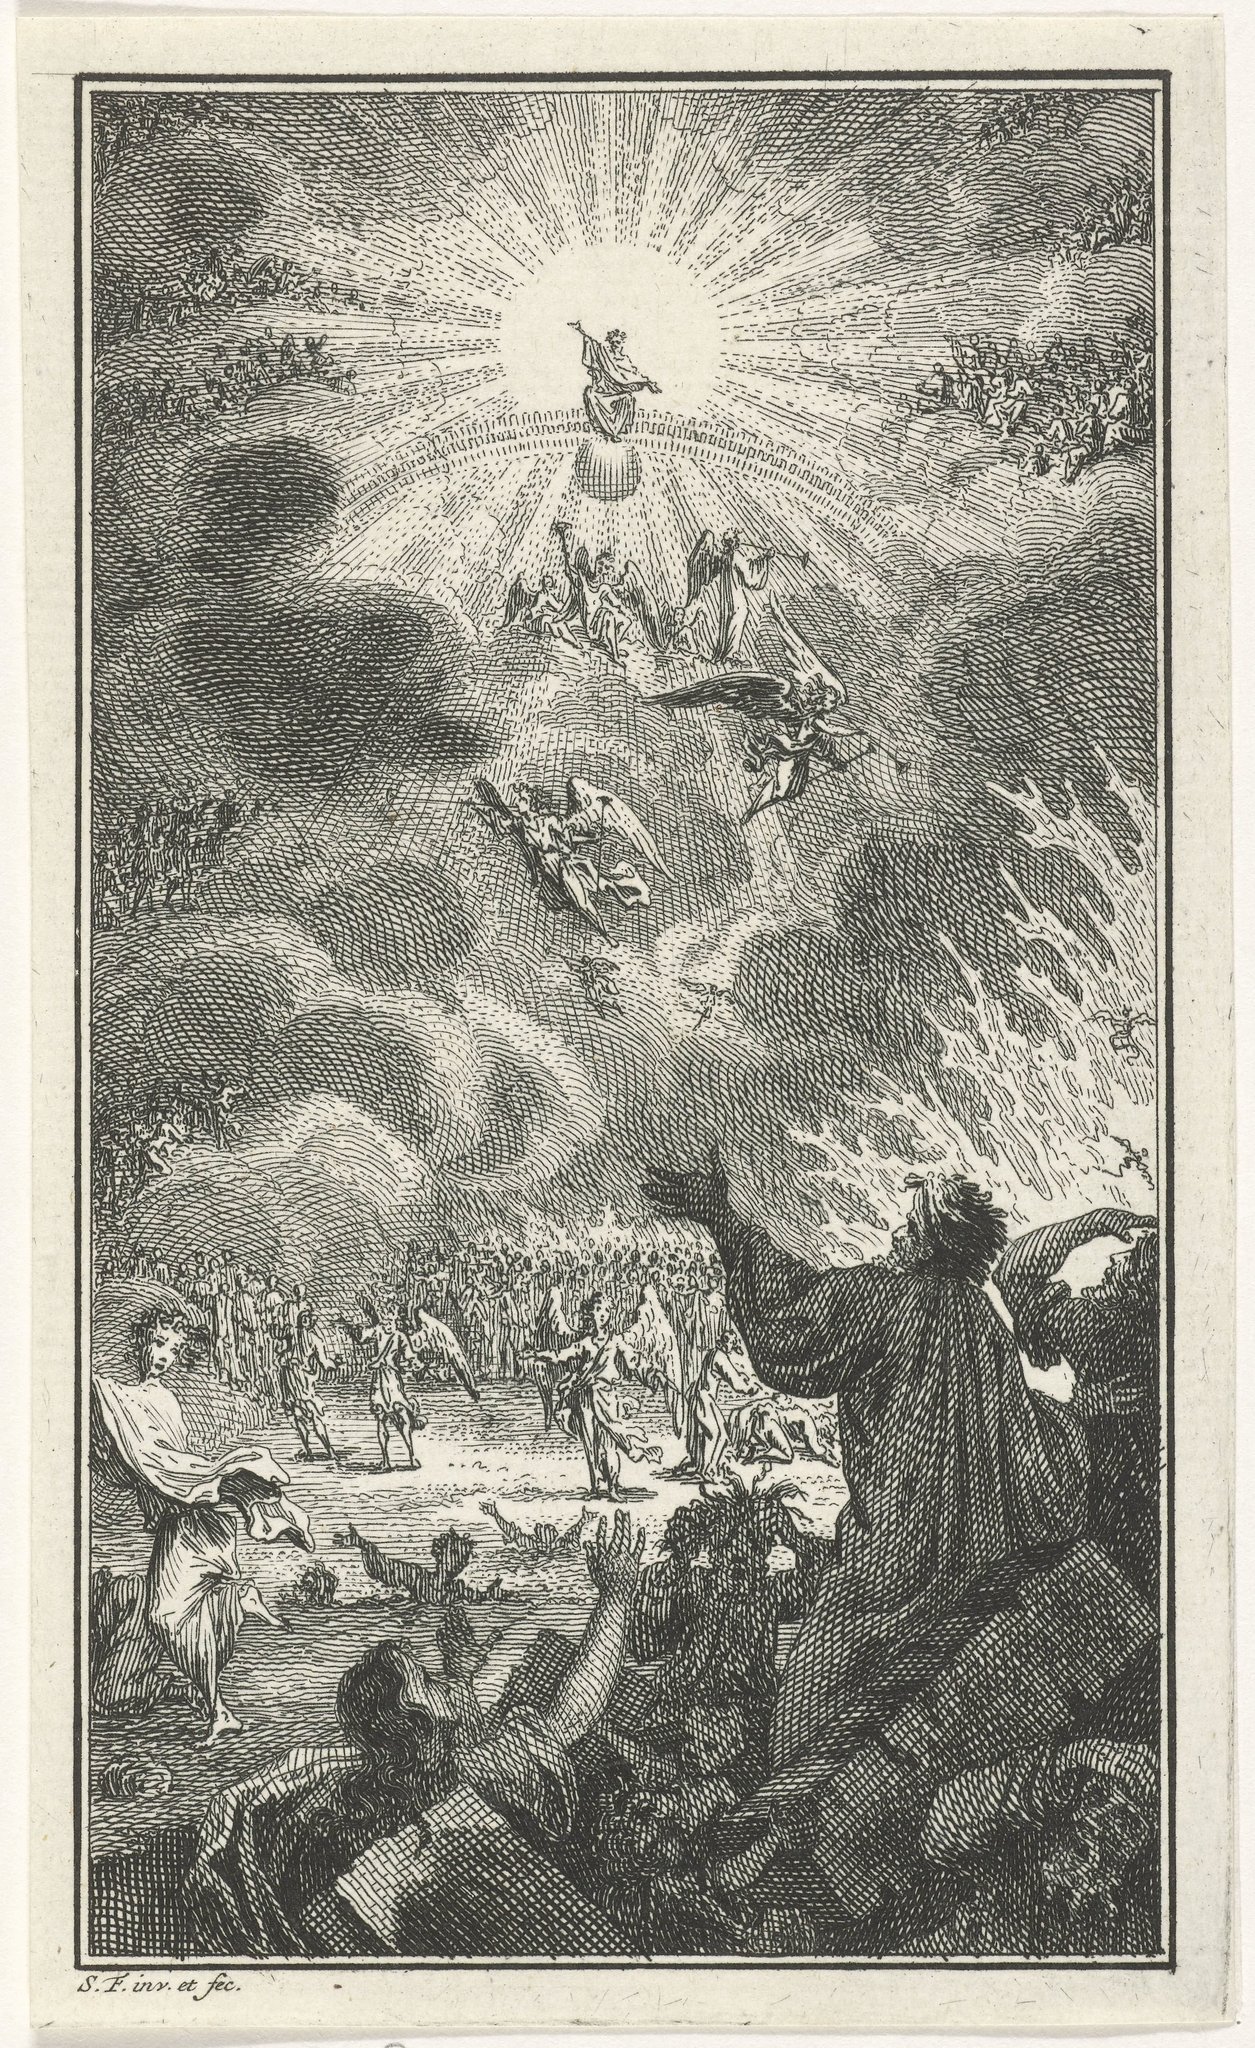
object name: print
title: Laatste Oordeel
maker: simon fokke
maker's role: draughtsman, print maker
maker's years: 1712-1784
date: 1722-1784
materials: paper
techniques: etching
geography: amsterdam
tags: last judgement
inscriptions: collector's mark: Lugt 240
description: Christus troont als rechter op een regenboog in de hemel; zijn voeten rusten op een wereldbol. Onder hem worden de zielen naar de hemel of hel geleid. Op aarde staan de doden op uit hun graf om verdeeld te worden tussen engelen en duivels.